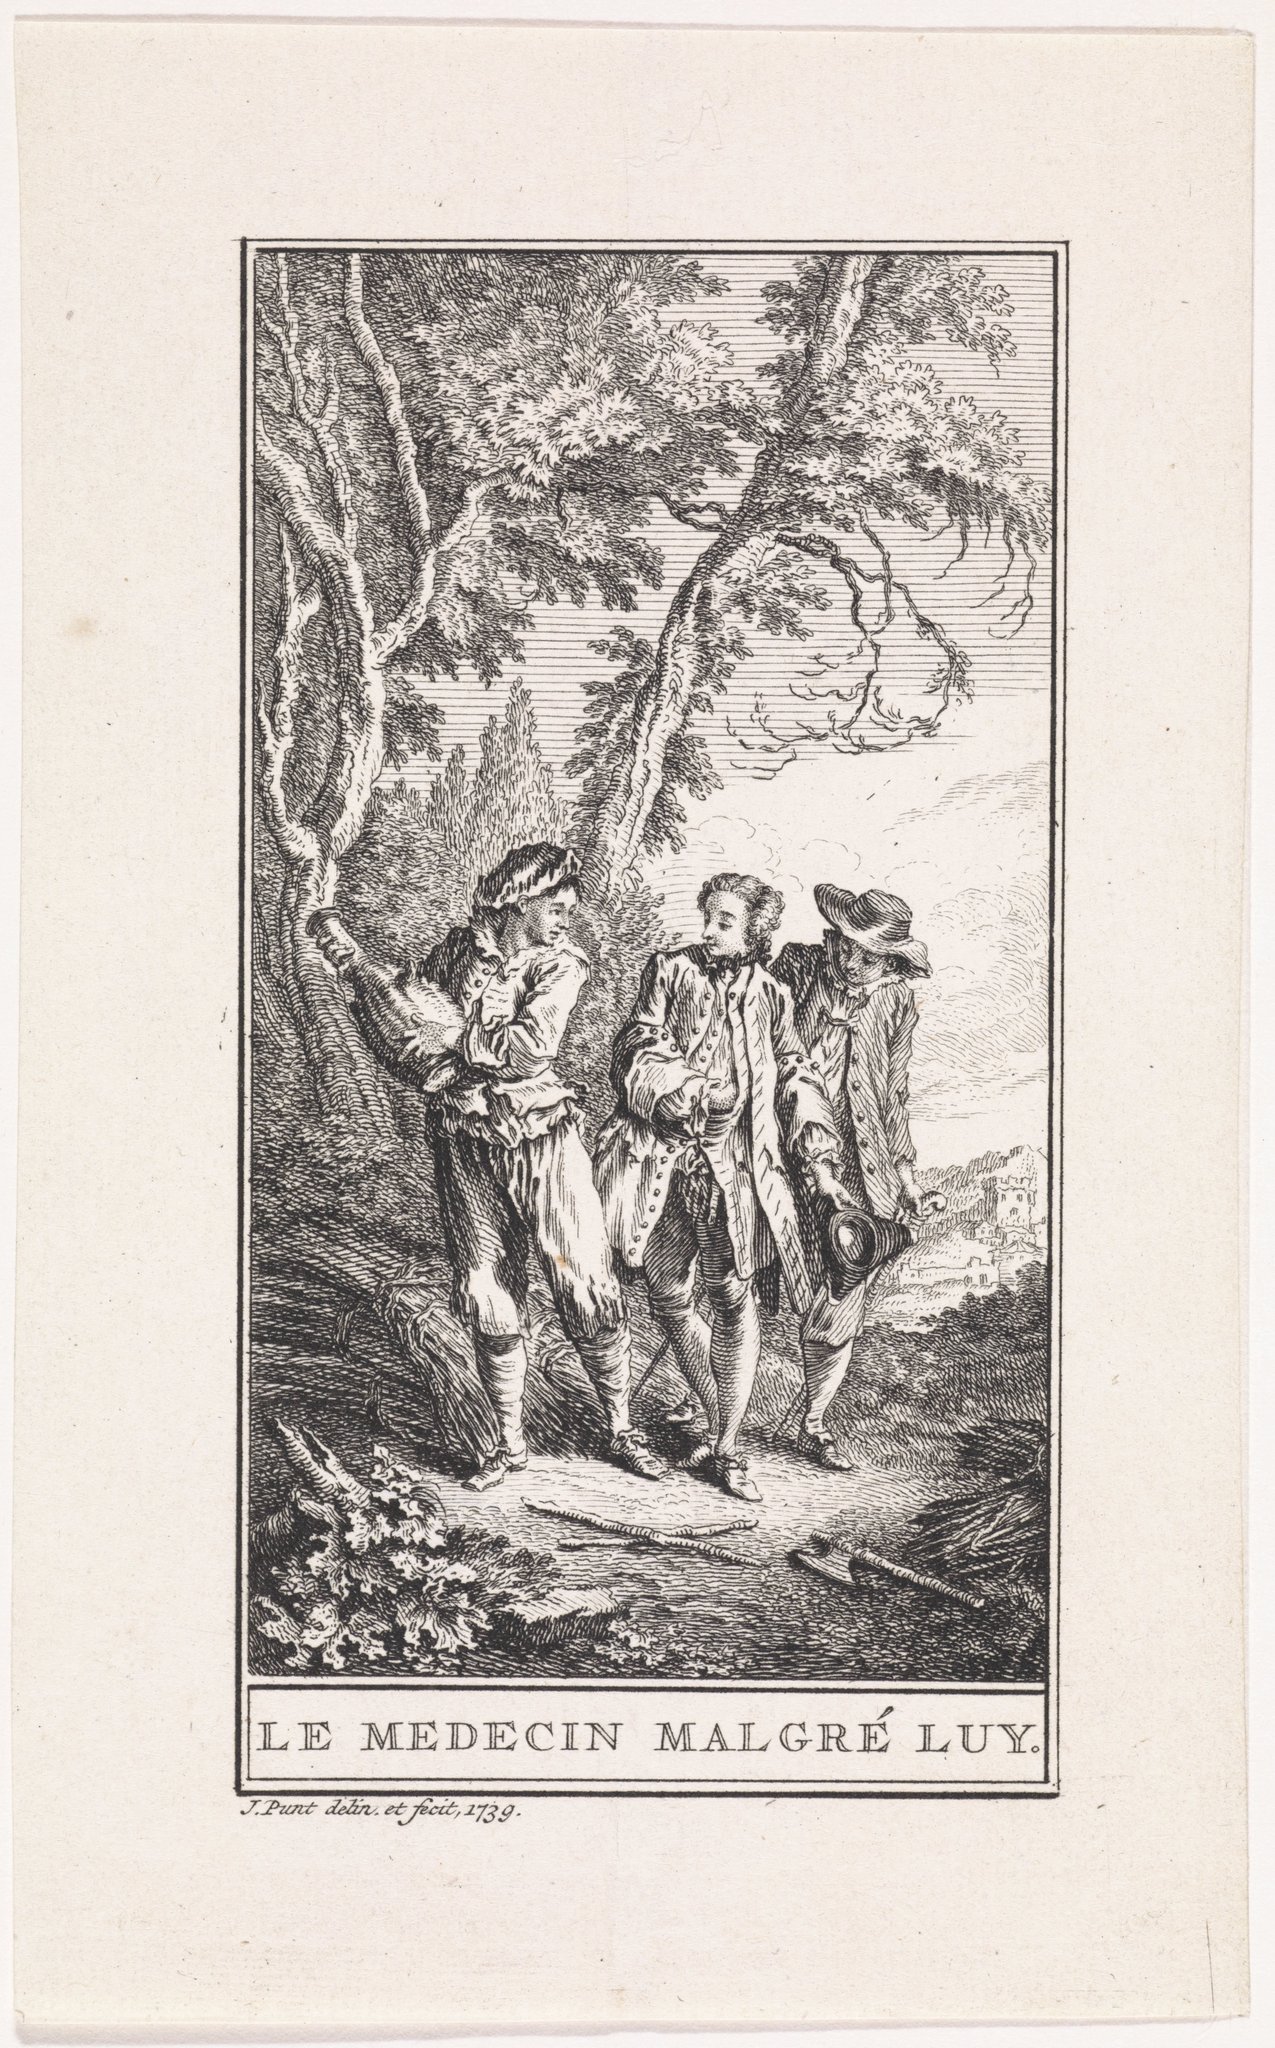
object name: print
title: Le médecin malgré luy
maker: jan punt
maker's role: draughtsman, print maker, publisher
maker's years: 1711-1779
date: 1739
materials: paper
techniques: engraving, etching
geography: amsterdam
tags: (moliere) specific works of literature (with author, title), forest, wood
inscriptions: collector's mark: Lugt 2228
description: Drie mannen wandelen over een pad door het bos. Degene die voorop loopt draagt een kruik. Scène uit het toneelstuk Le Médecin malgré lui (Dokter tegen wil en dank), van Molière.